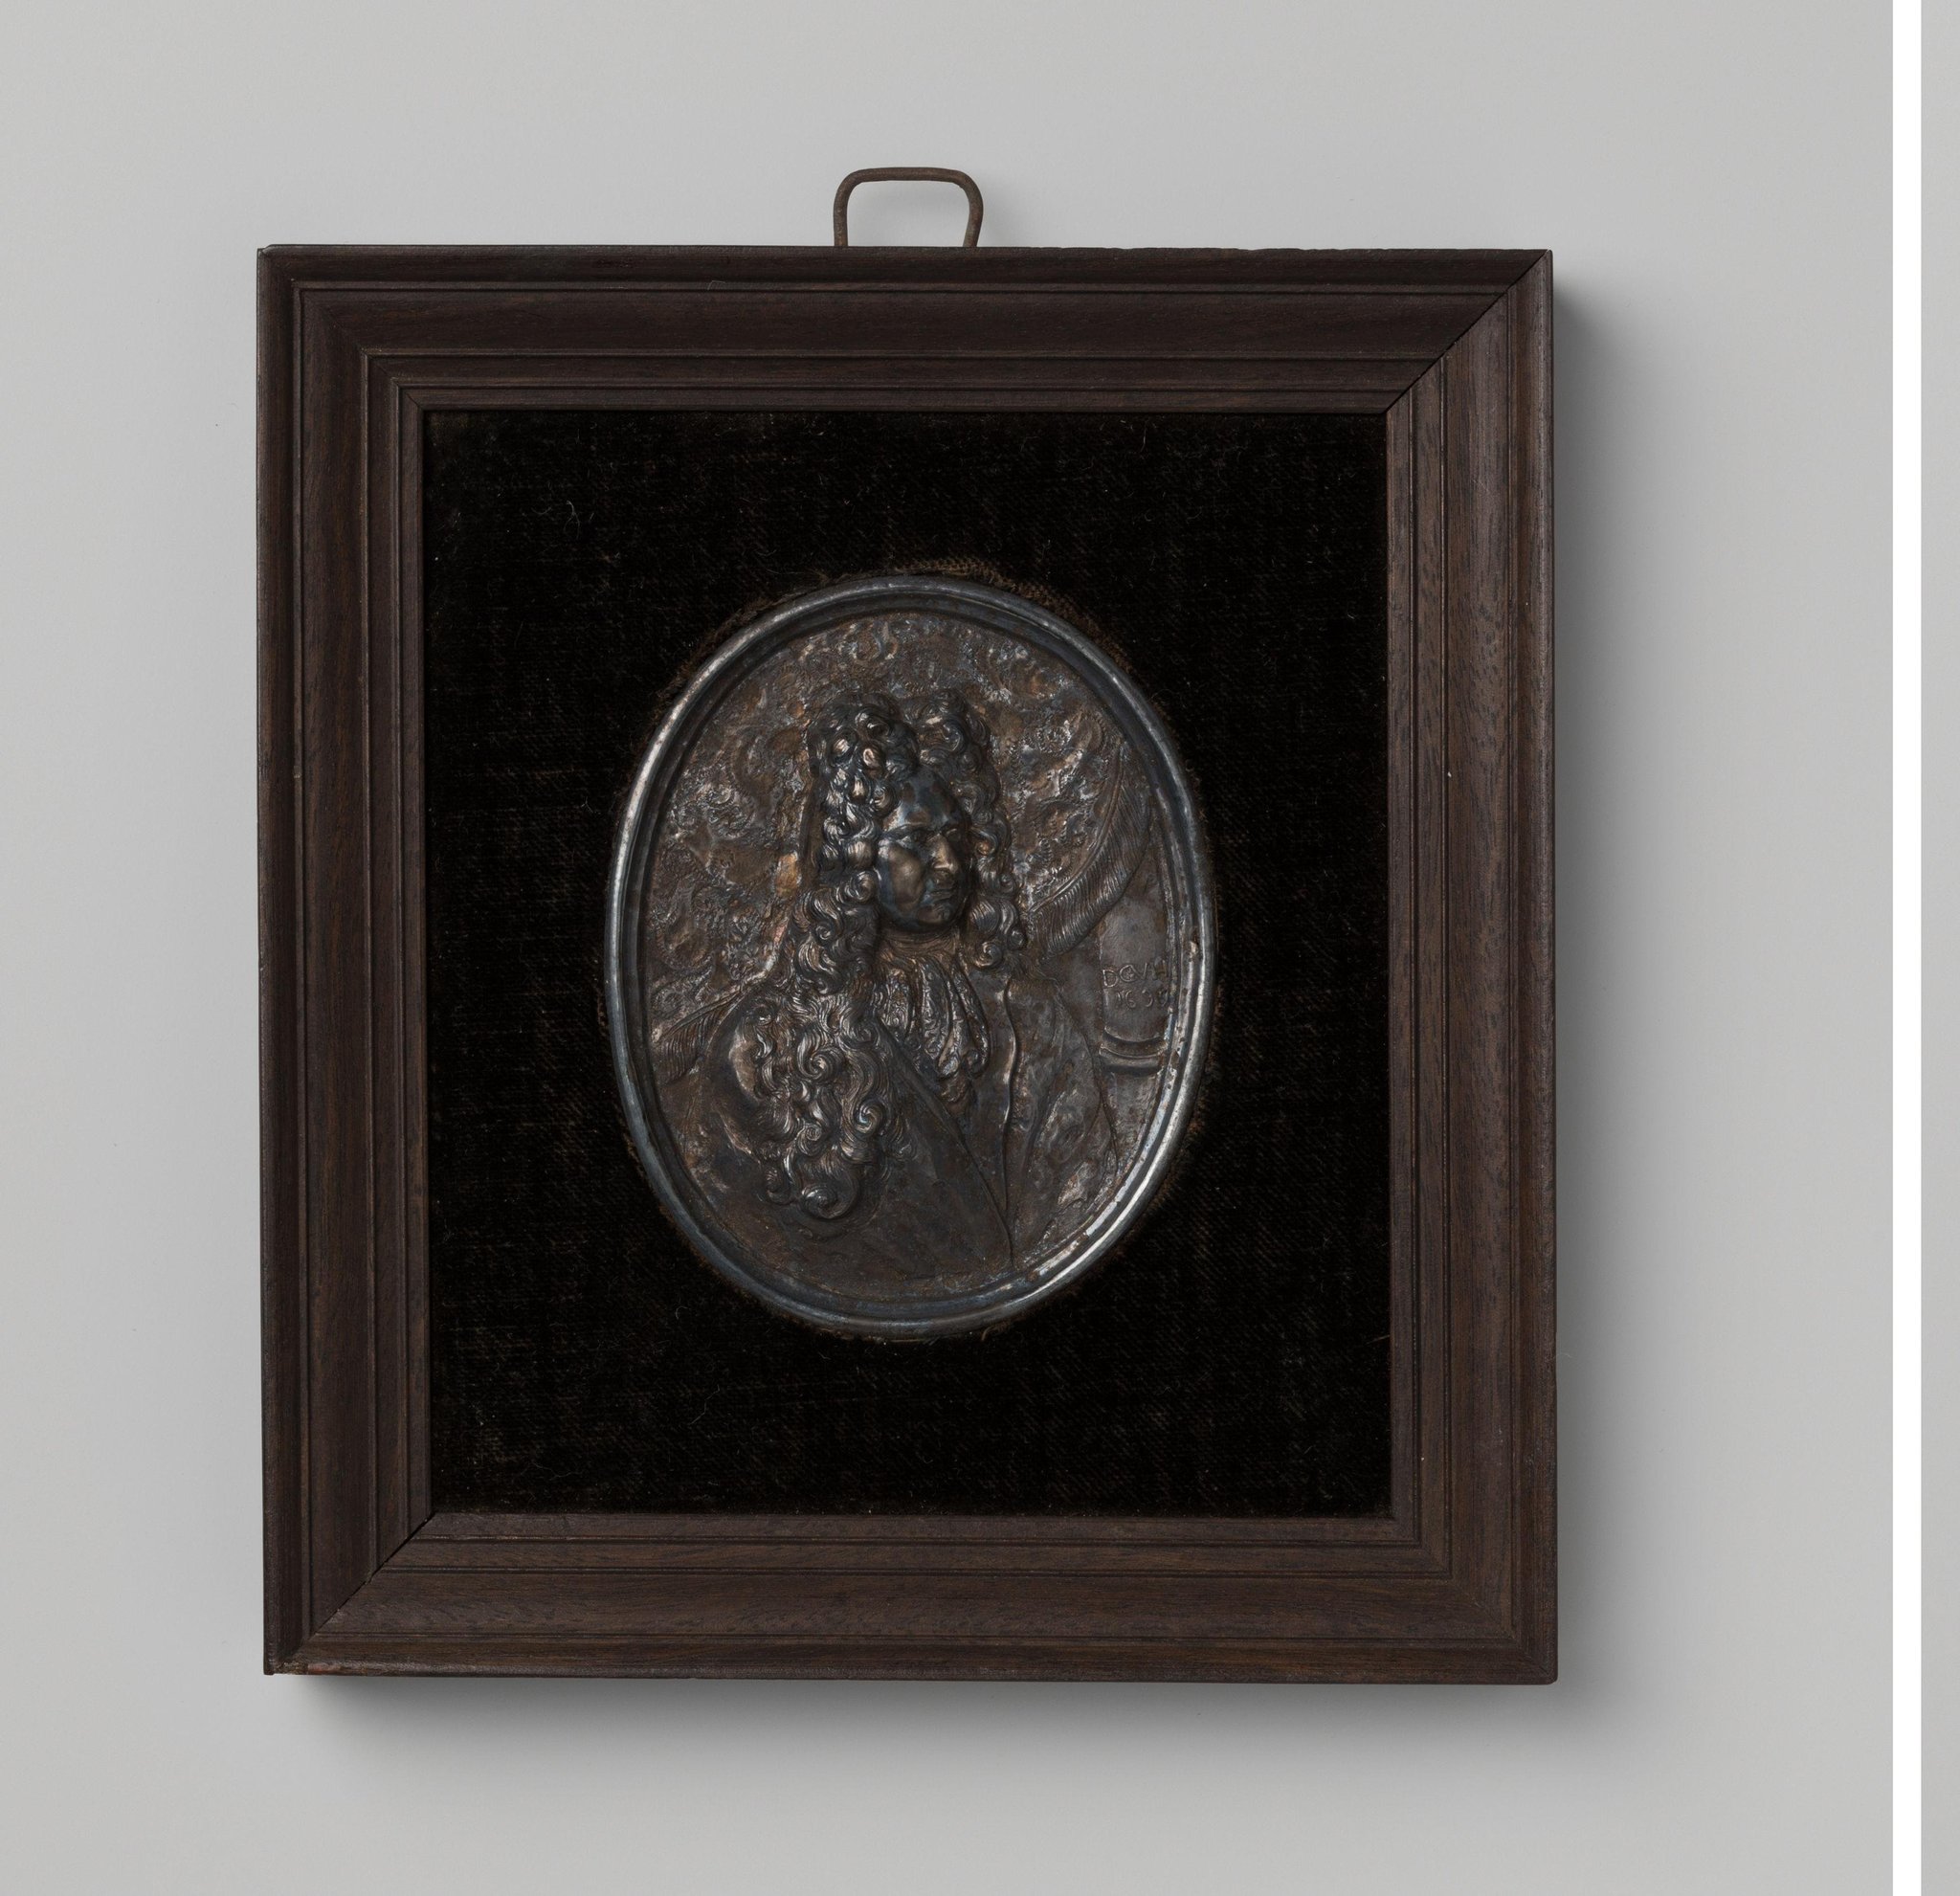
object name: honorary medal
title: Portret man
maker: monogrammist dgvh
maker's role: medailleur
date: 1695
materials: wood, silver, velvet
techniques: casting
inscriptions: date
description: Eenzijdige zilveren ovale penning in ebbenhouten lijstje op zwart fluwelen ondergrond. Voorzijde: borststuk man voor versierd gordijn; op achtergrond links zuil met monogram en datering. Keerzijde: blanco.